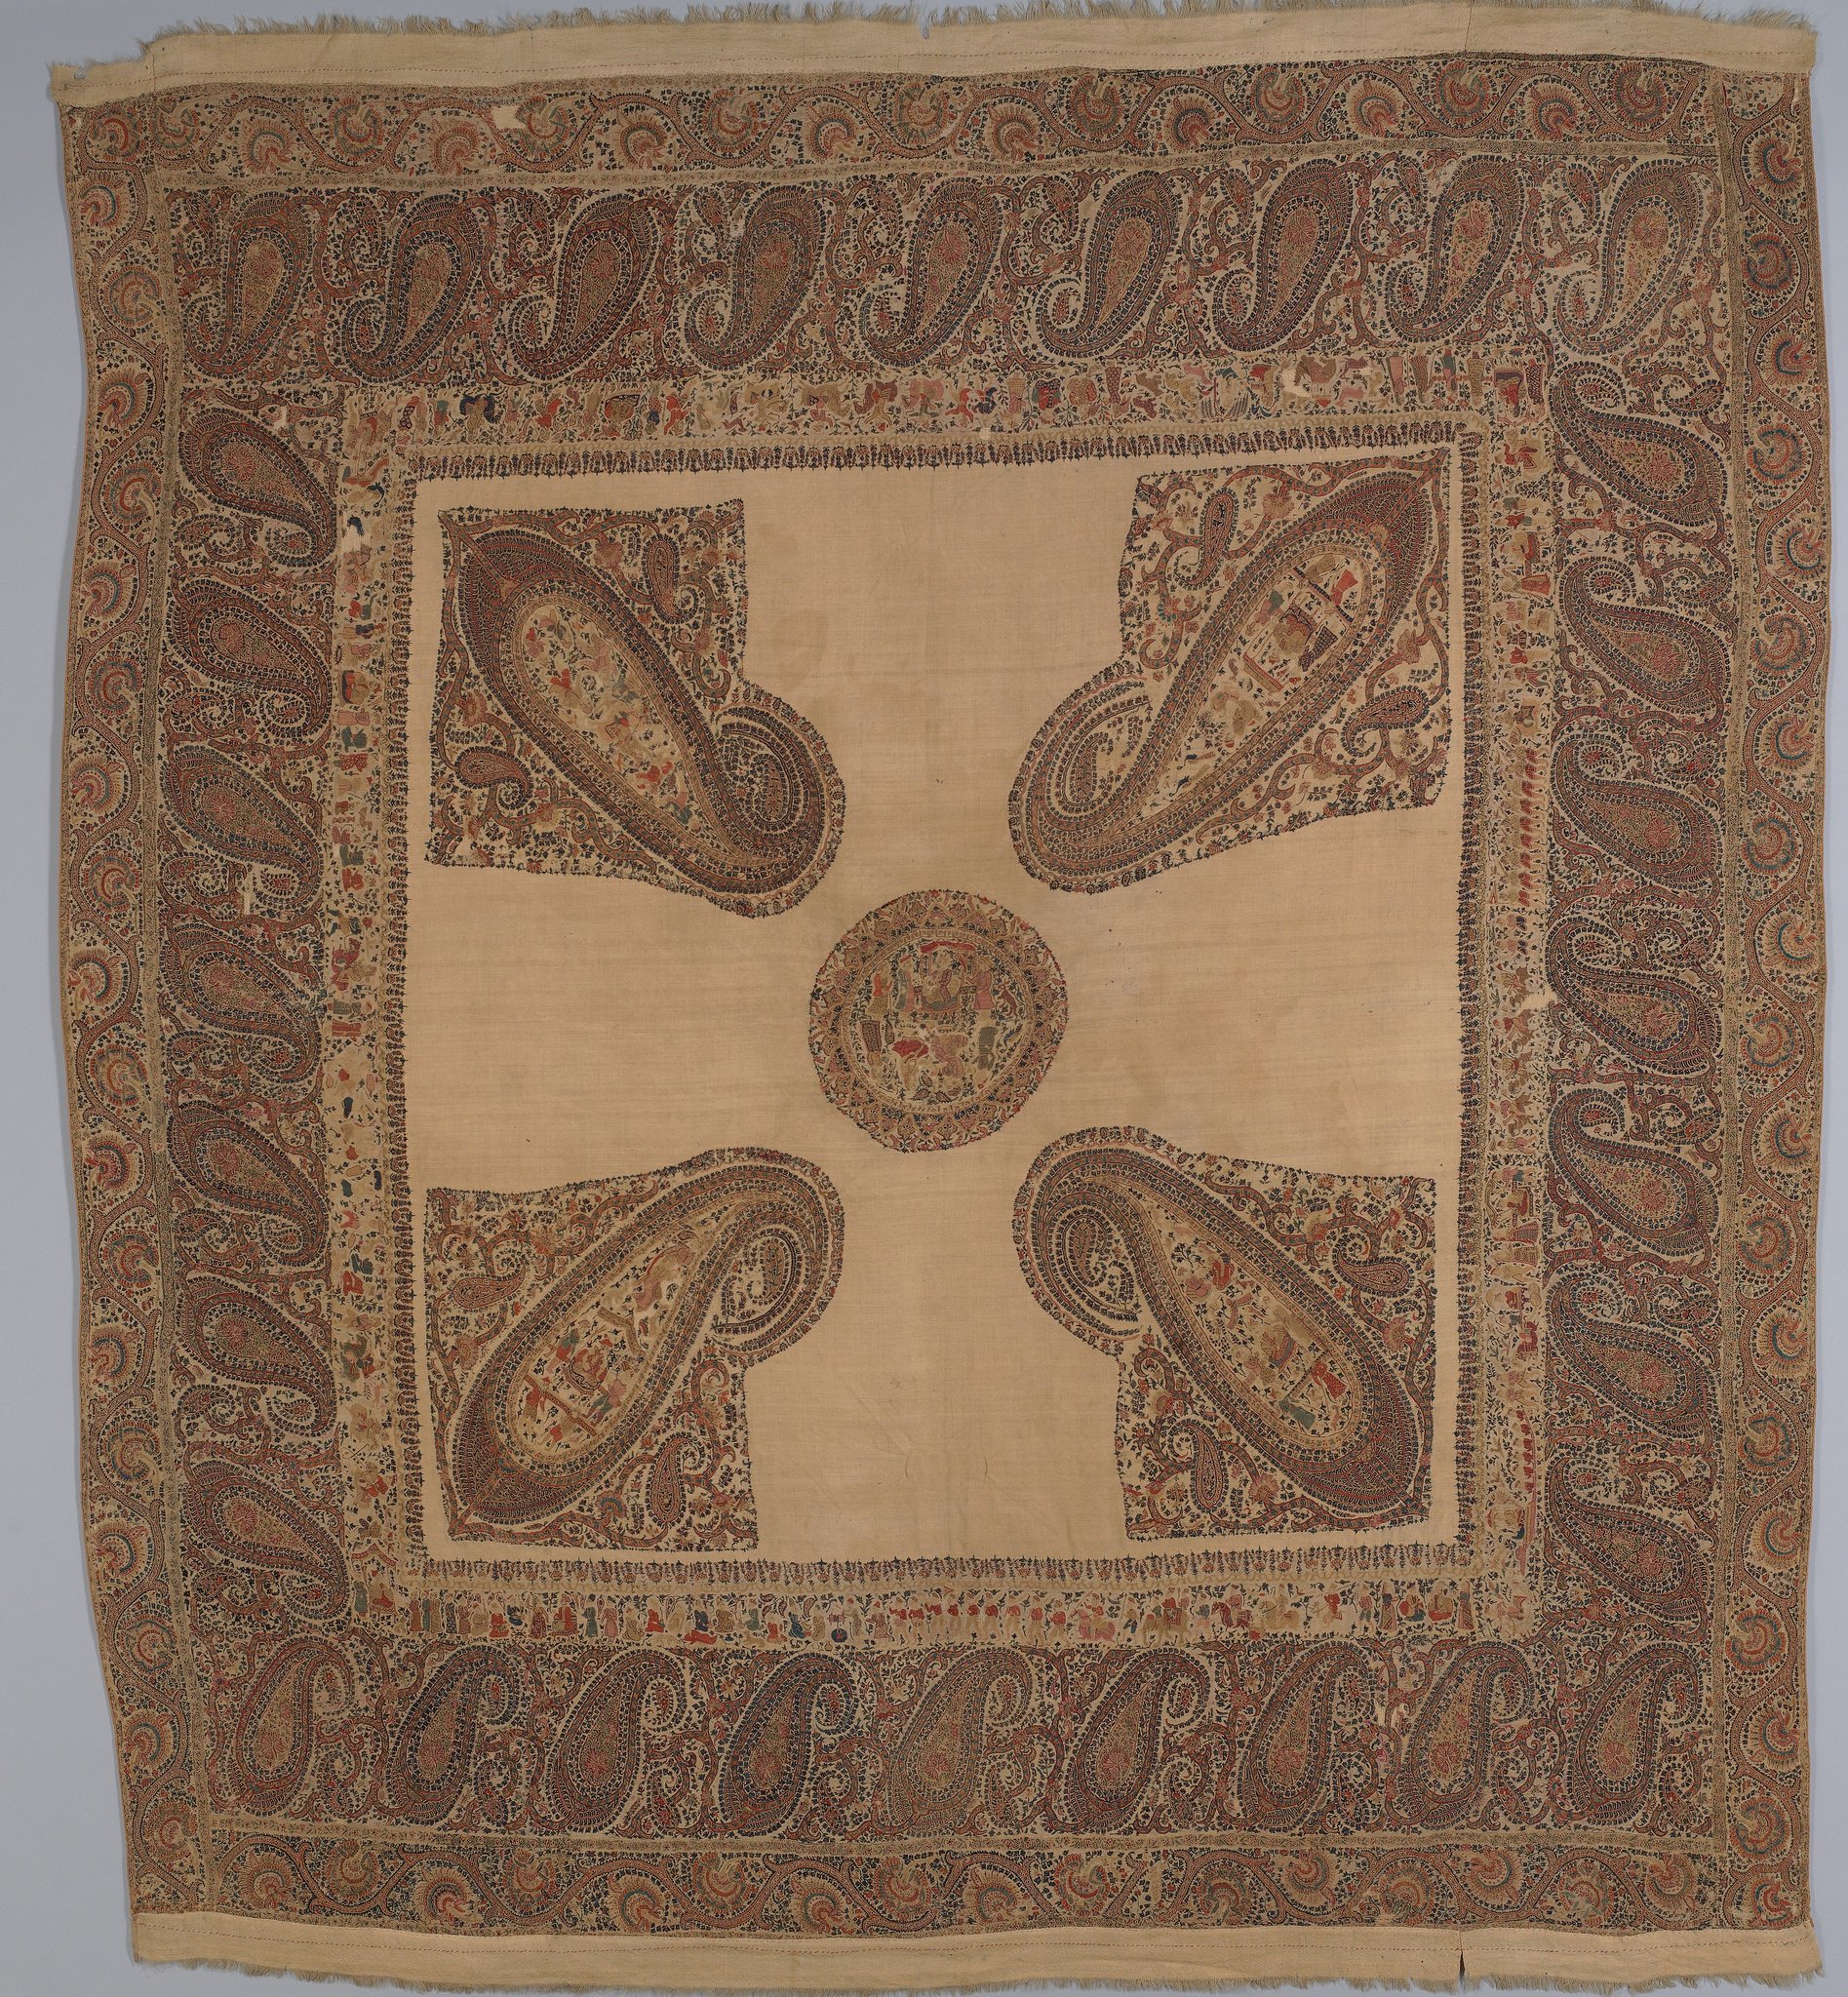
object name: shawl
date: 1834-1866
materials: panel, wool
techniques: embroidery, weave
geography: india